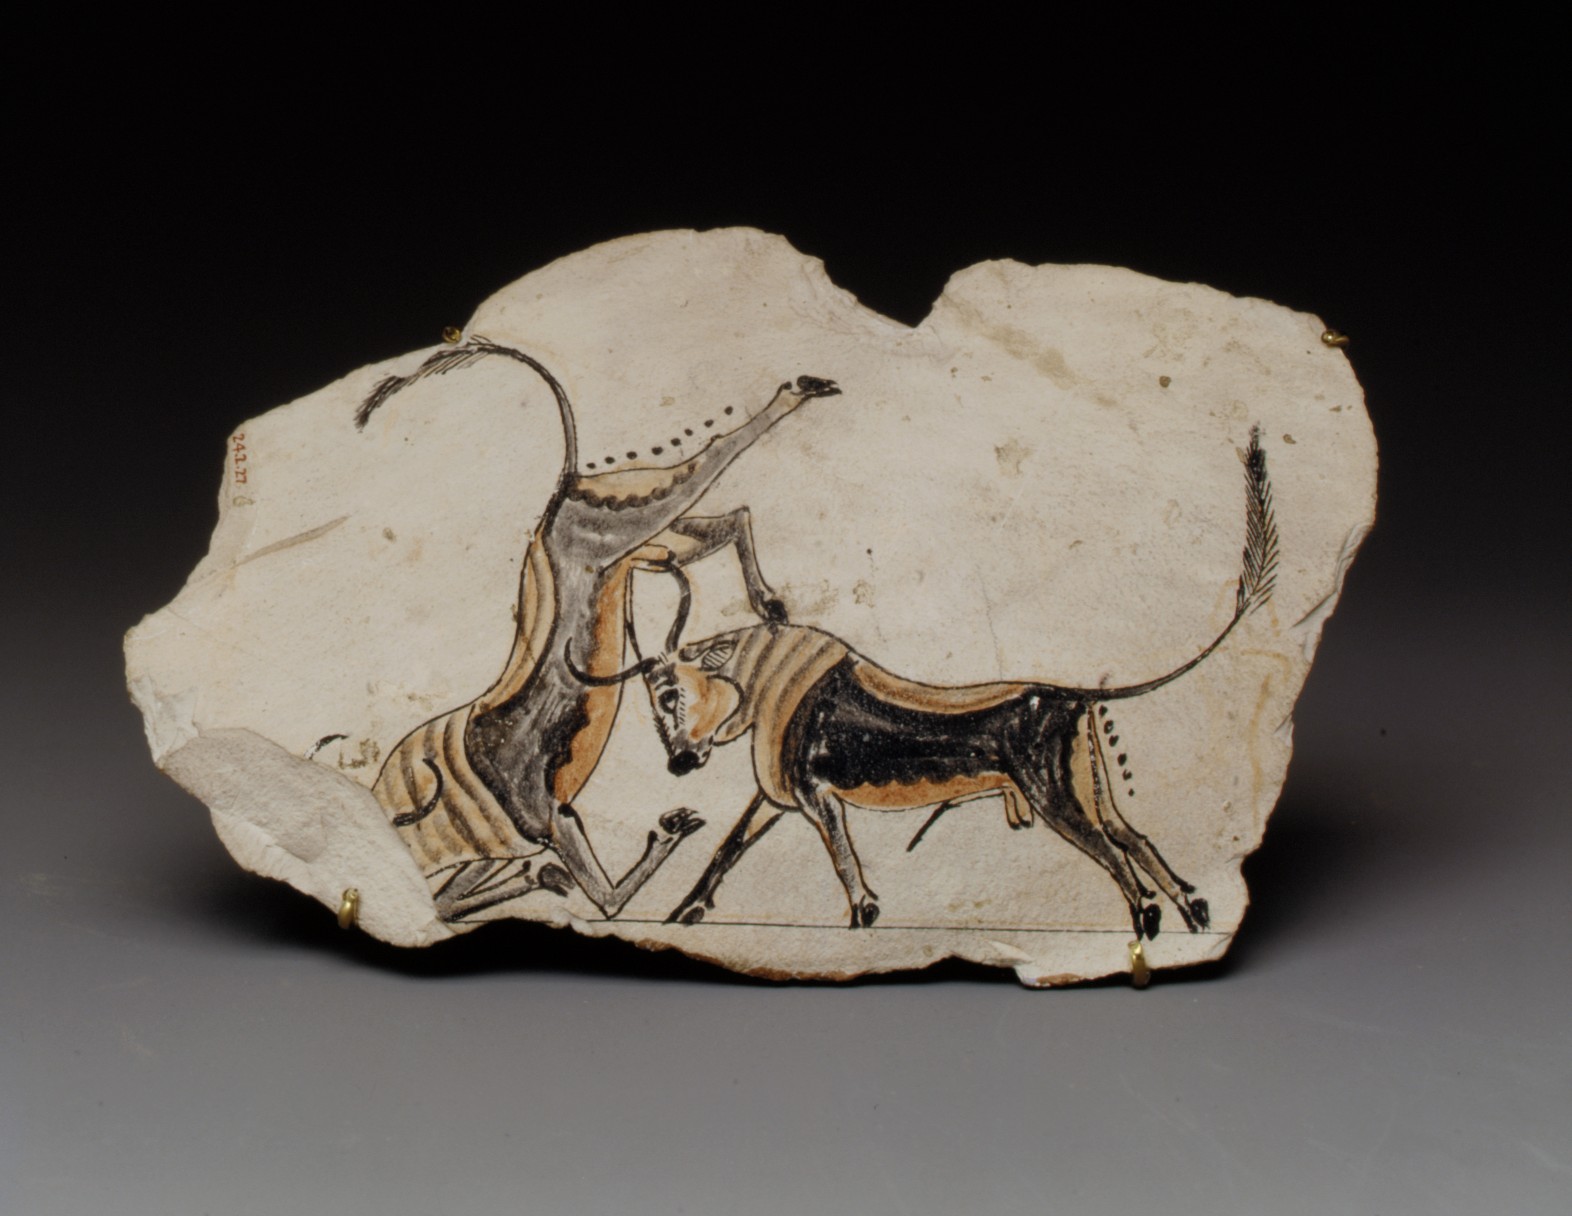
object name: ostracon, figured, fighting bull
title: Ostracon with fighting bulls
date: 1295-1070 BCE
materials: limestone, paint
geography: upper egypt, thebes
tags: bulls